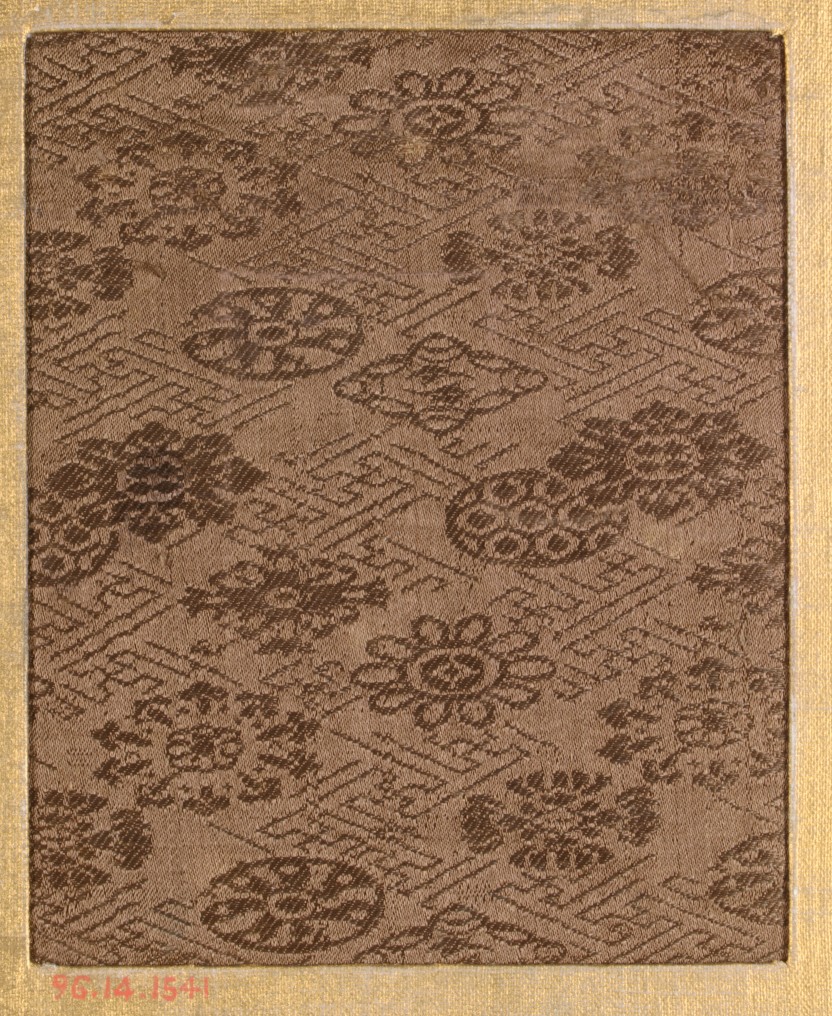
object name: piece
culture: japanese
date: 1701-1900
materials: silk